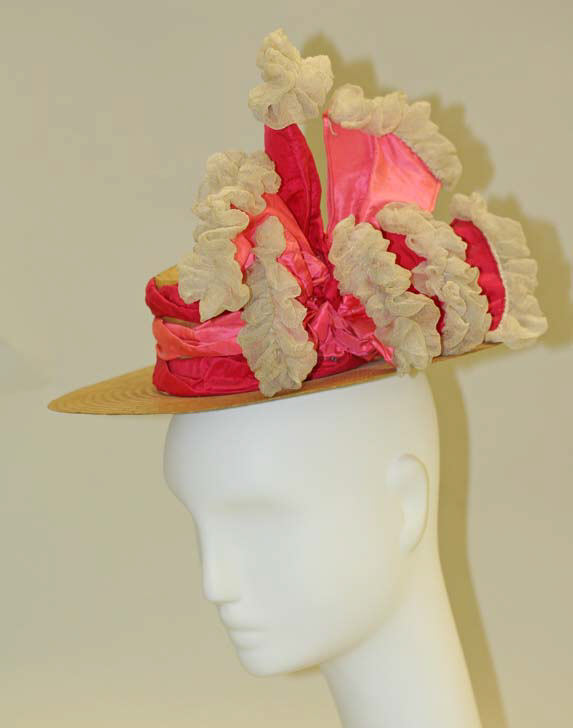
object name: hat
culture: scottish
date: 1900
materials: silk, fiber